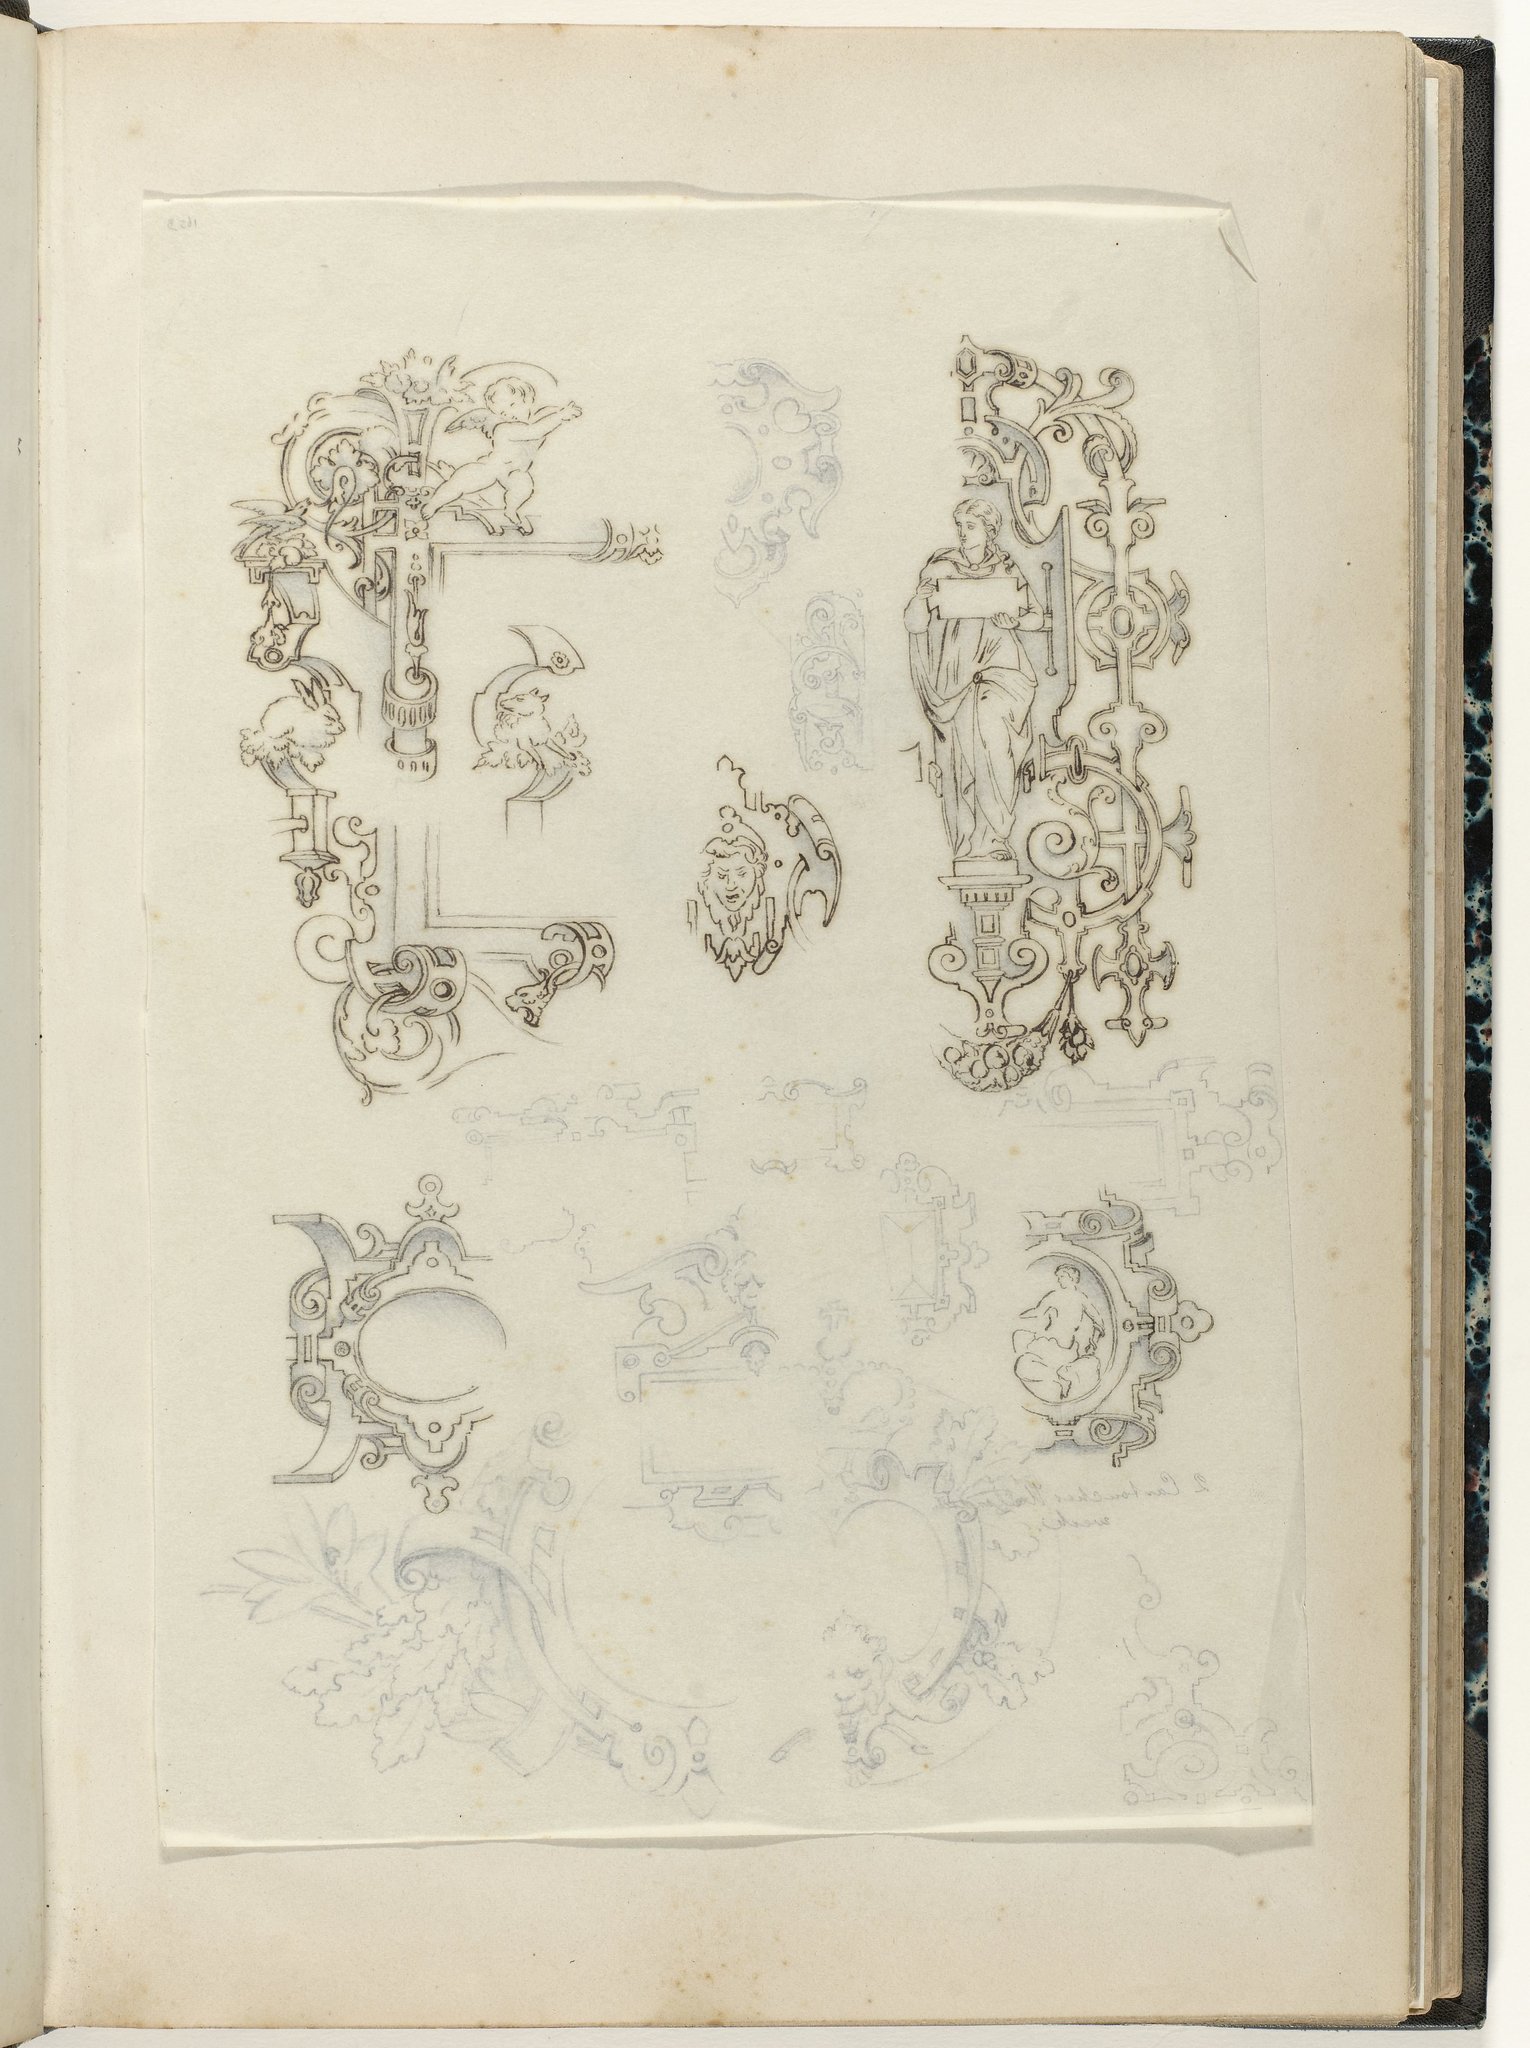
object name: drawing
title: Halve cartouches en ornamenten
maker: Anonymous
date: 1866-1900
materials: ink, pencil, paper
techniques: drawing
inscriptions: annotation: ‘2 Cartouches Hollandsch werk.’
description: Linksboven staat een figuur op een voetstuk voor een cartouche van beslagwerk en bladranken. De figuur heeft een lege cartouche in de handen.